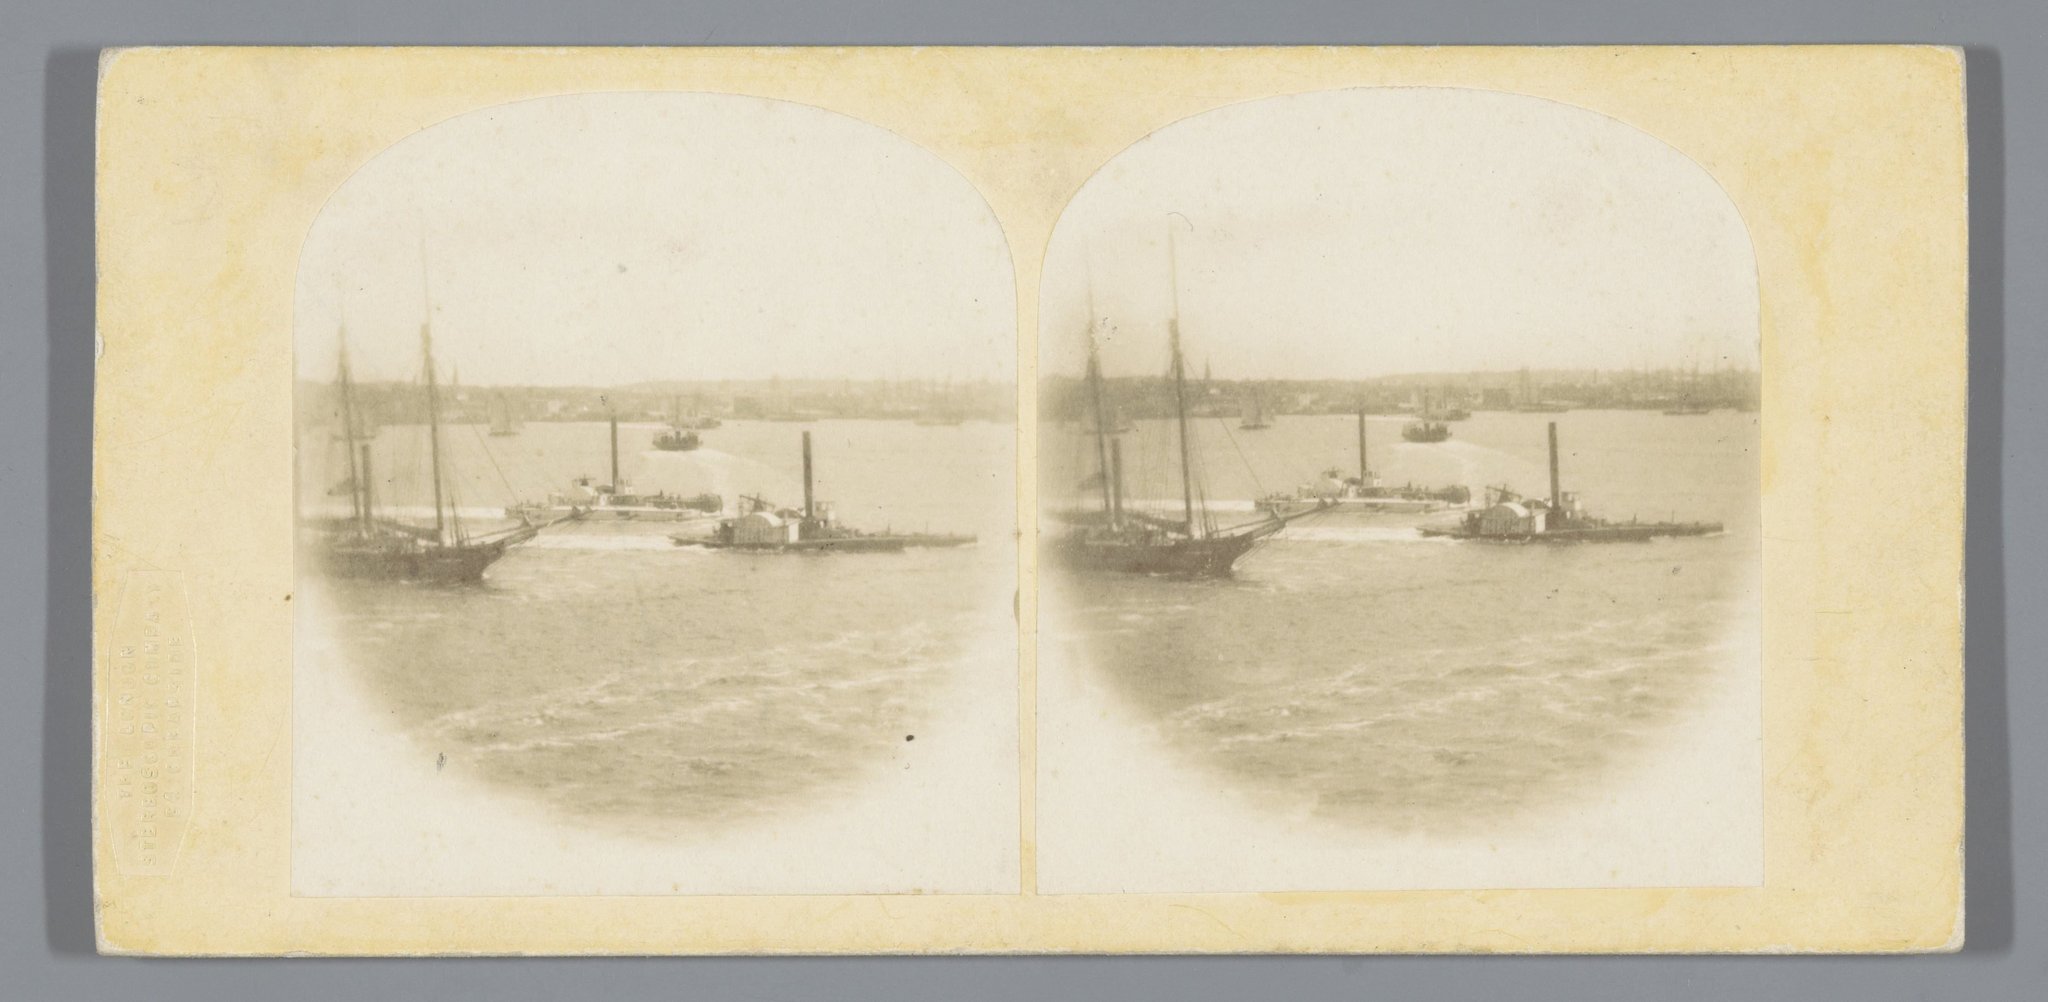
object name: stereograph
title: United States of America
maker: william england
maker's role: fotograaf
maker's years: 1816-1896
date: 1859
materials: cardboard, paper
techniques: albumen print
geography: new york city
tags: gulf, bay, ships (in general) - cc - more than one ship, new york (city)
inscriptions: : ‘The accompanying photograph (...) the silent tides."’